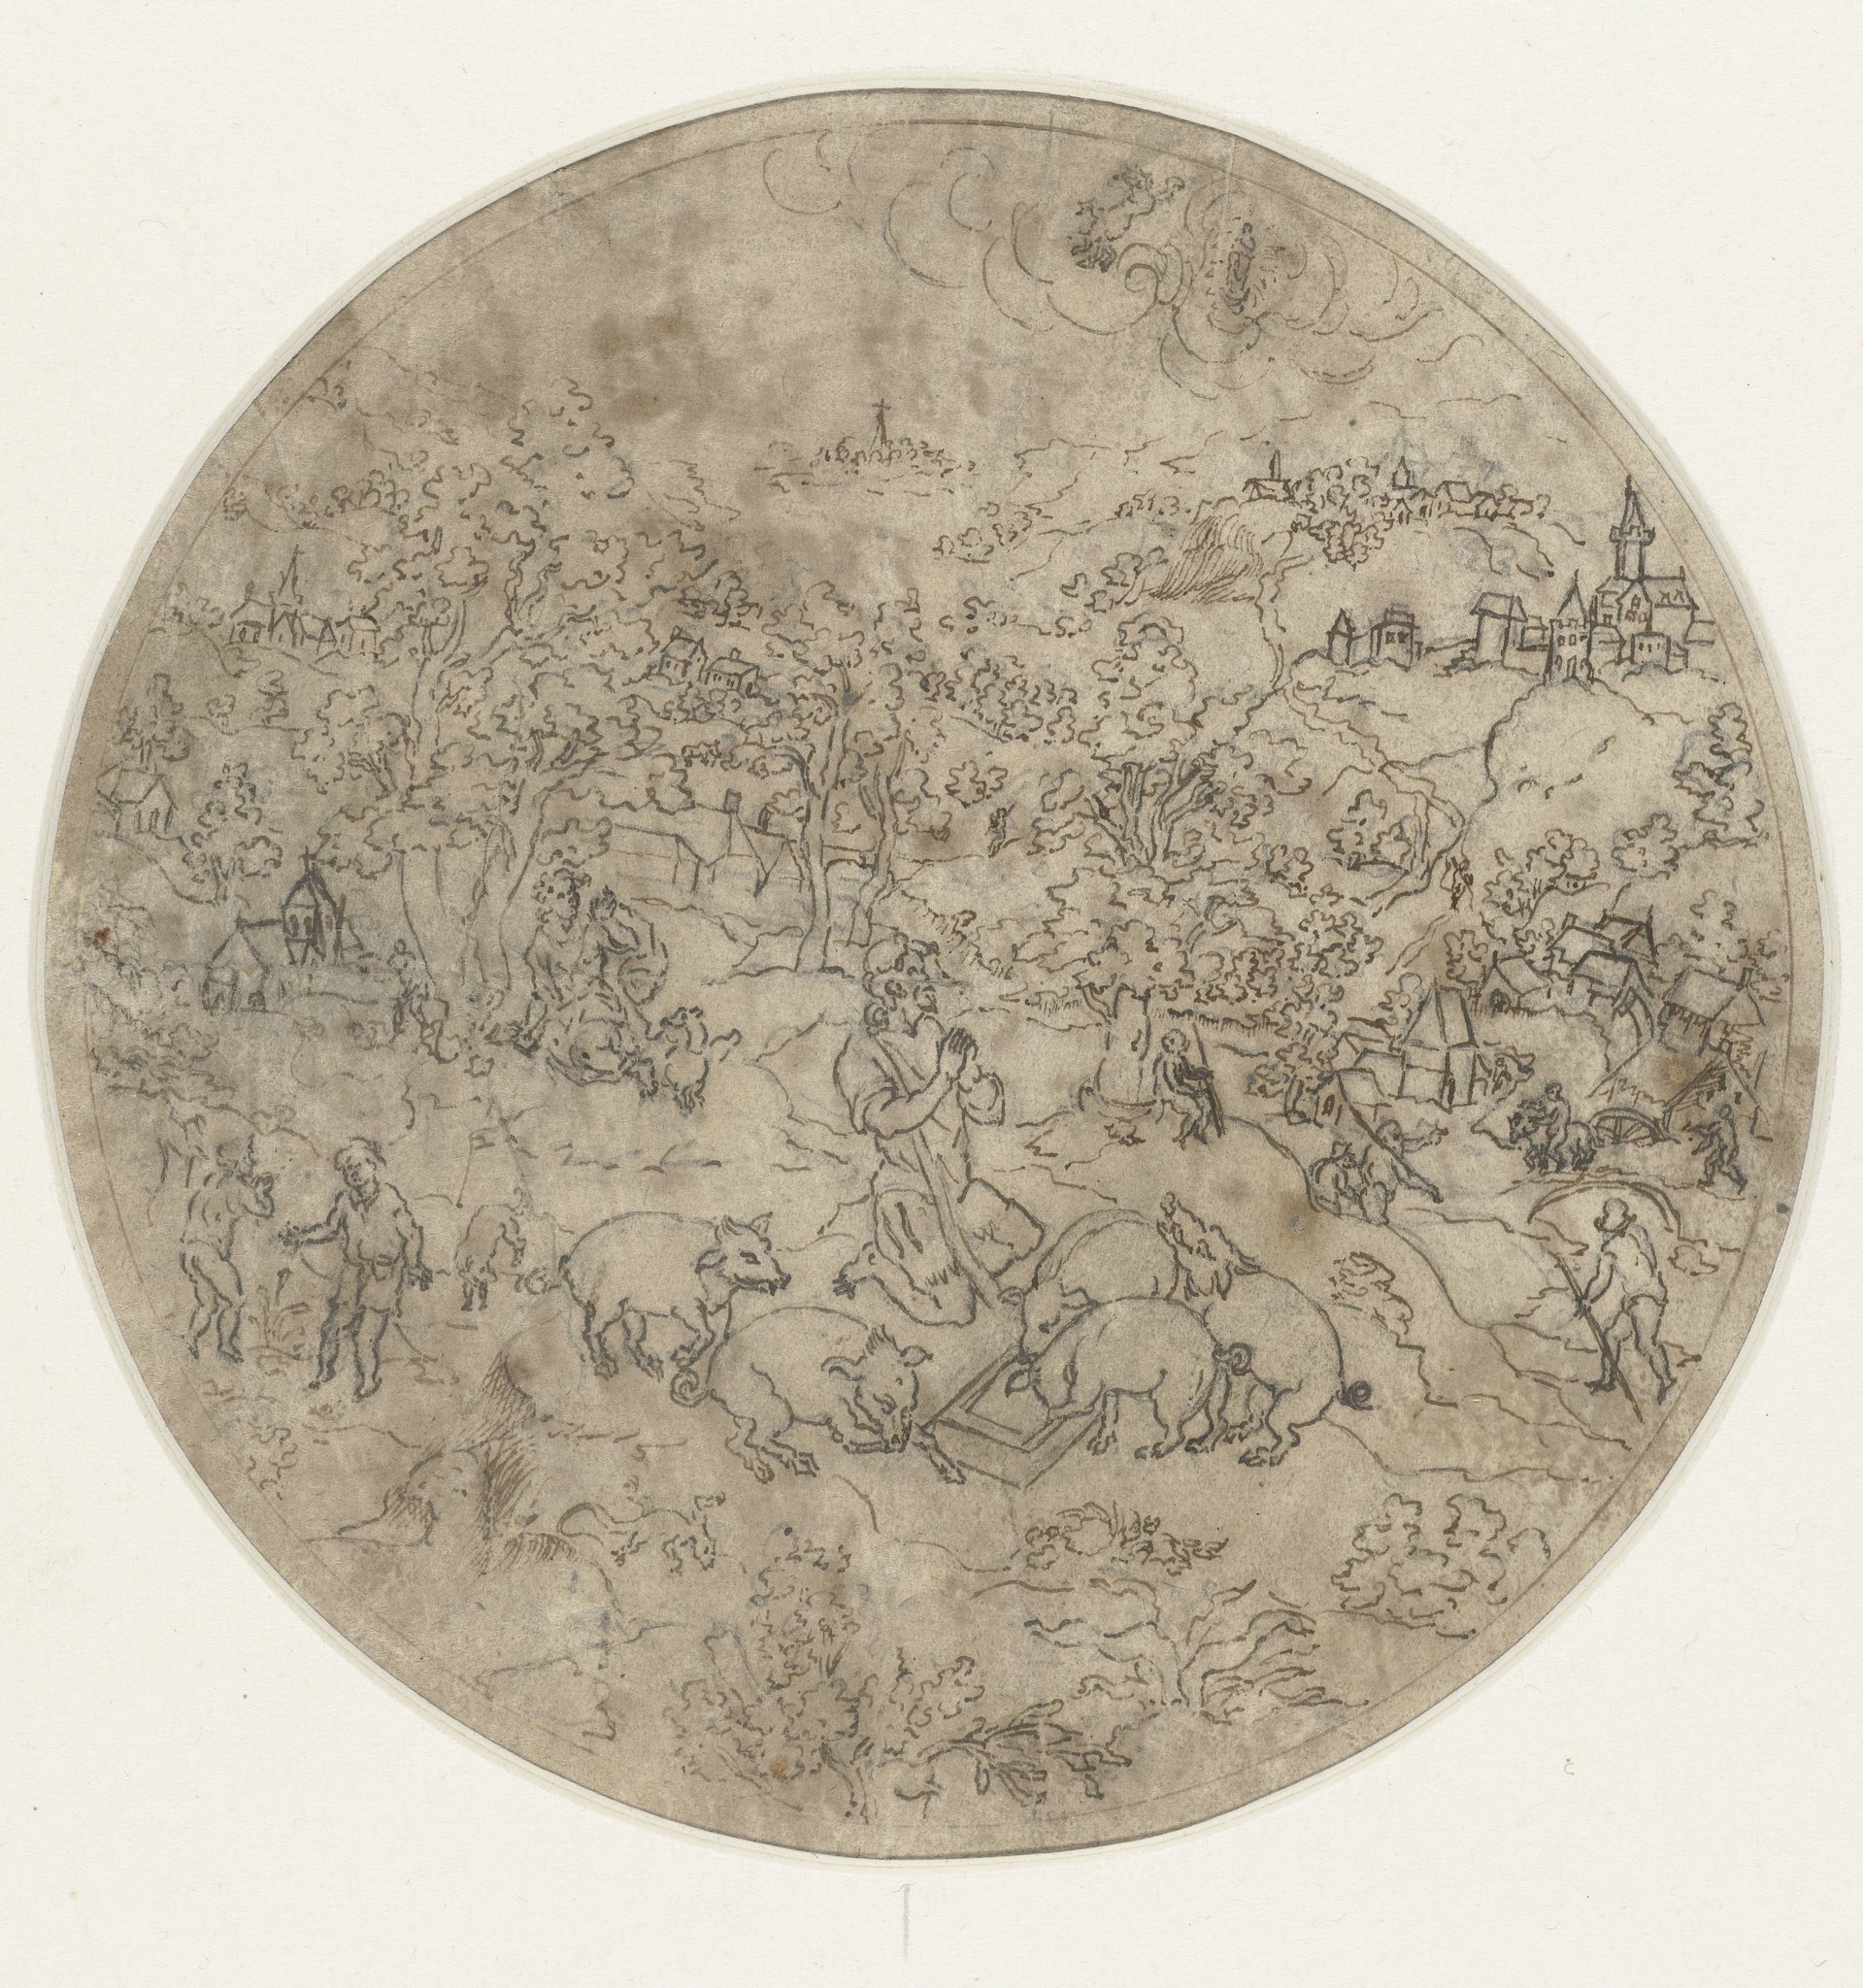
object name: drawing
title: Verloren Zoon als veehoeder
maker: jonas silber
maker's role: draughtsman, jeweler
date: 1572-1589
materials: ink, paper, pencil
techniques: pen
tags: the prodigal son repents his former life and prays